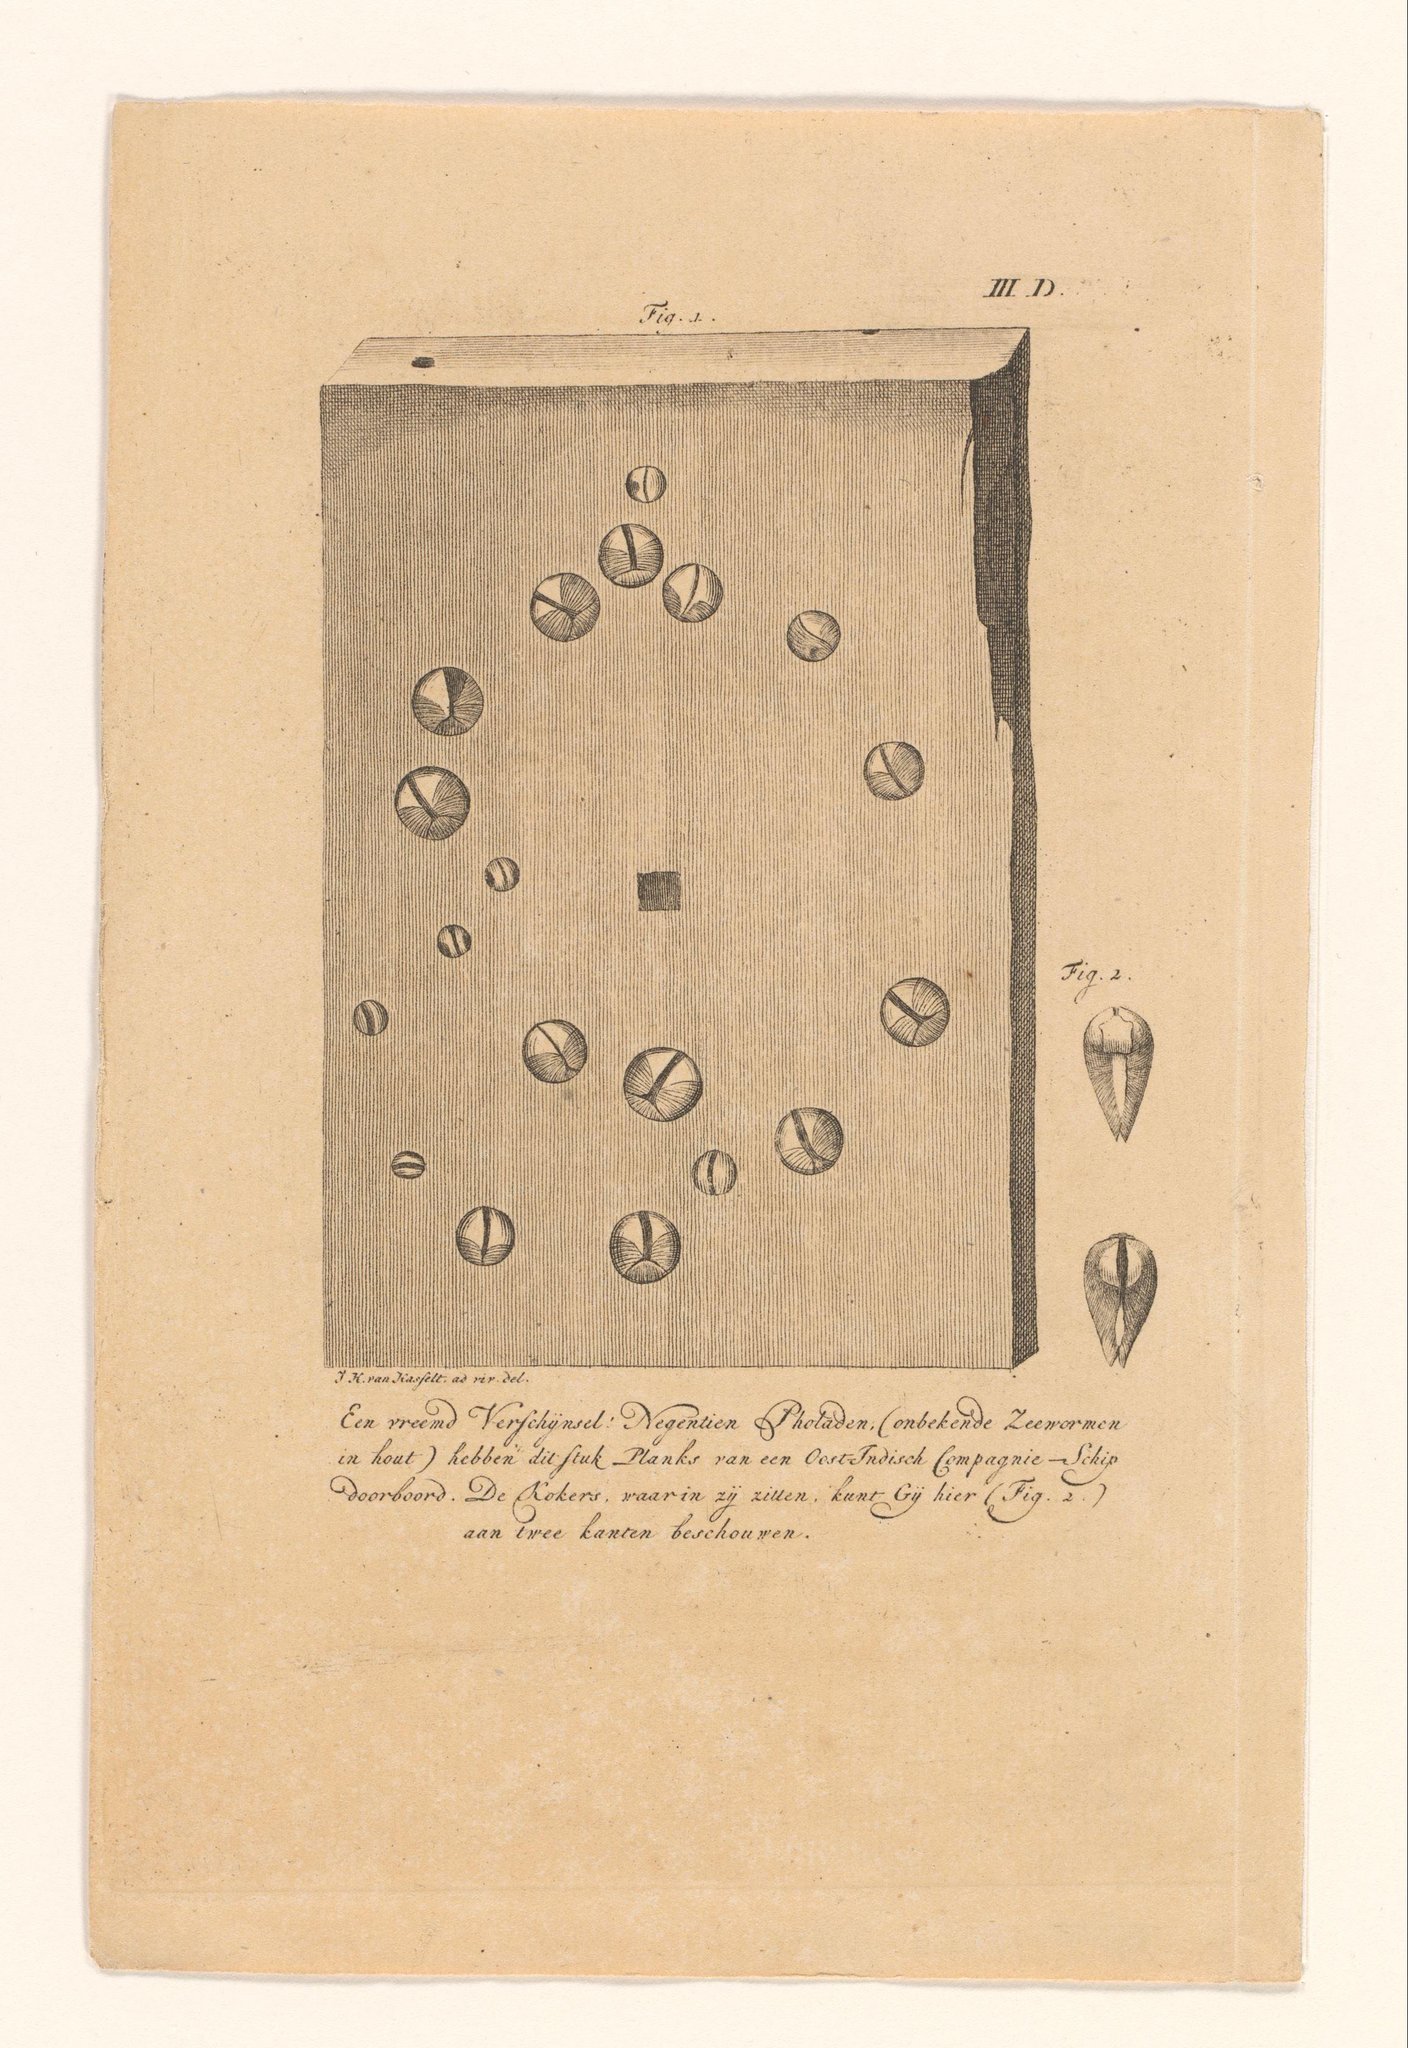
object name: print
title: Houten plank van een schip van de Oost-Indische Compagnie met zeewormen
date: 1778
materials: paper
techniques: engraving, etching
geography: northern netherlands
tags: worms, plank, board ~ building material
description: Prent waarschijnlijk uit: Martinet, J.F. Kateschismus der Natuur. Amsterdam: Johannes Allart, dl. 3.